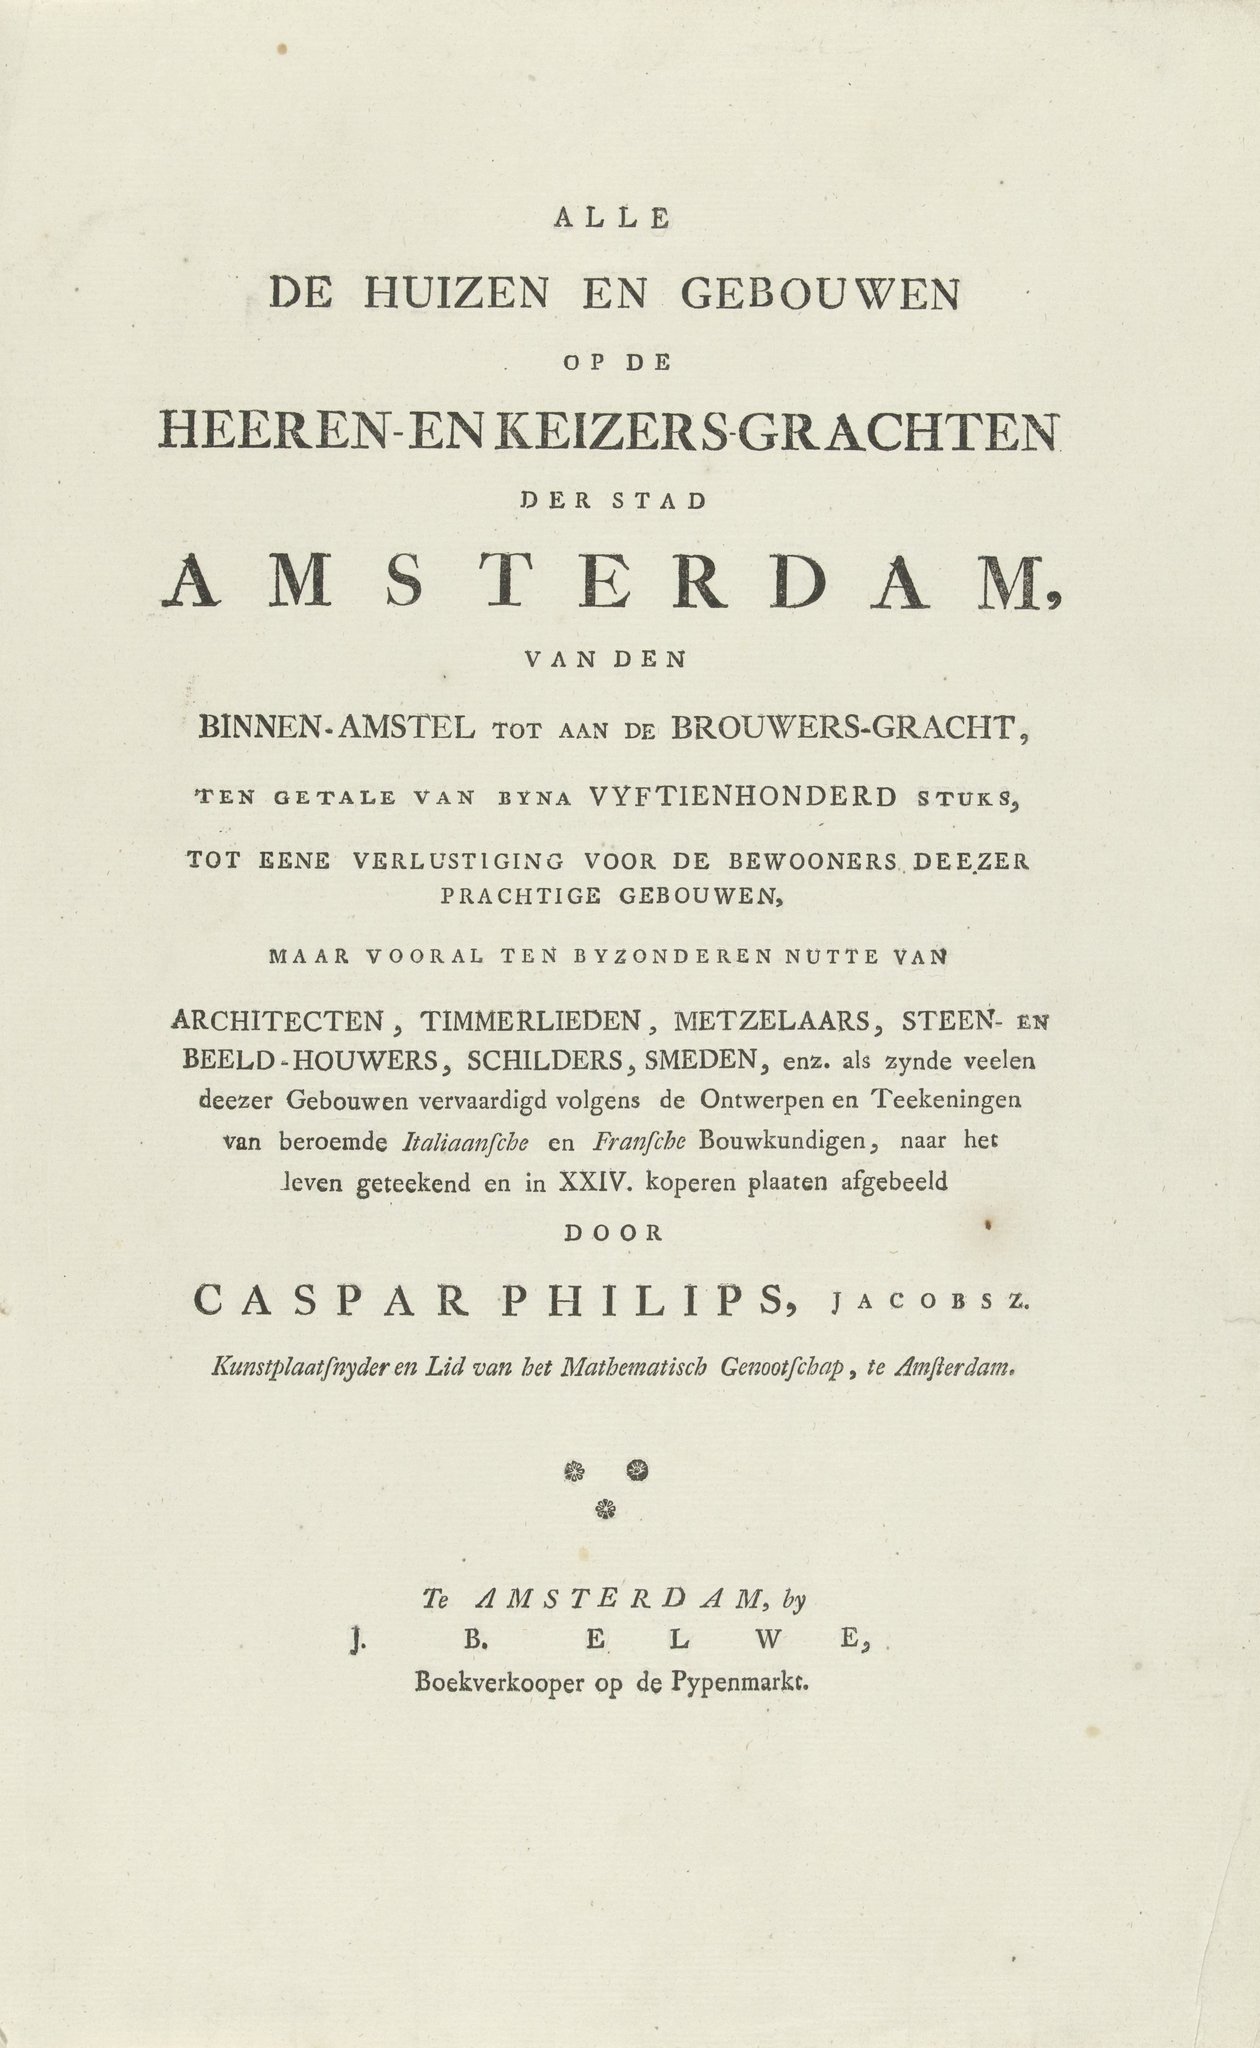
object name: titelblad, titelpagina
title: Titelpagina voor: Alle de huizen en gebouwen op de Heeren- en Keizers-grachten der stad Amsterdam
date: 1772-1800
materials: paper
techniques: letterpress printing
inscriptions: collector's mark: Lugt 2228, collector's mark: Lugt 2233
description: Titelpagina voor: Alle de huizen en gebouwen op de Heeren- en Keizers-grachten der stad Amsterdam, van den Binnen-Amstel tot aan de Brouwers-gracht. Amsterdam: Jan Barend Elwe, [sine anno].